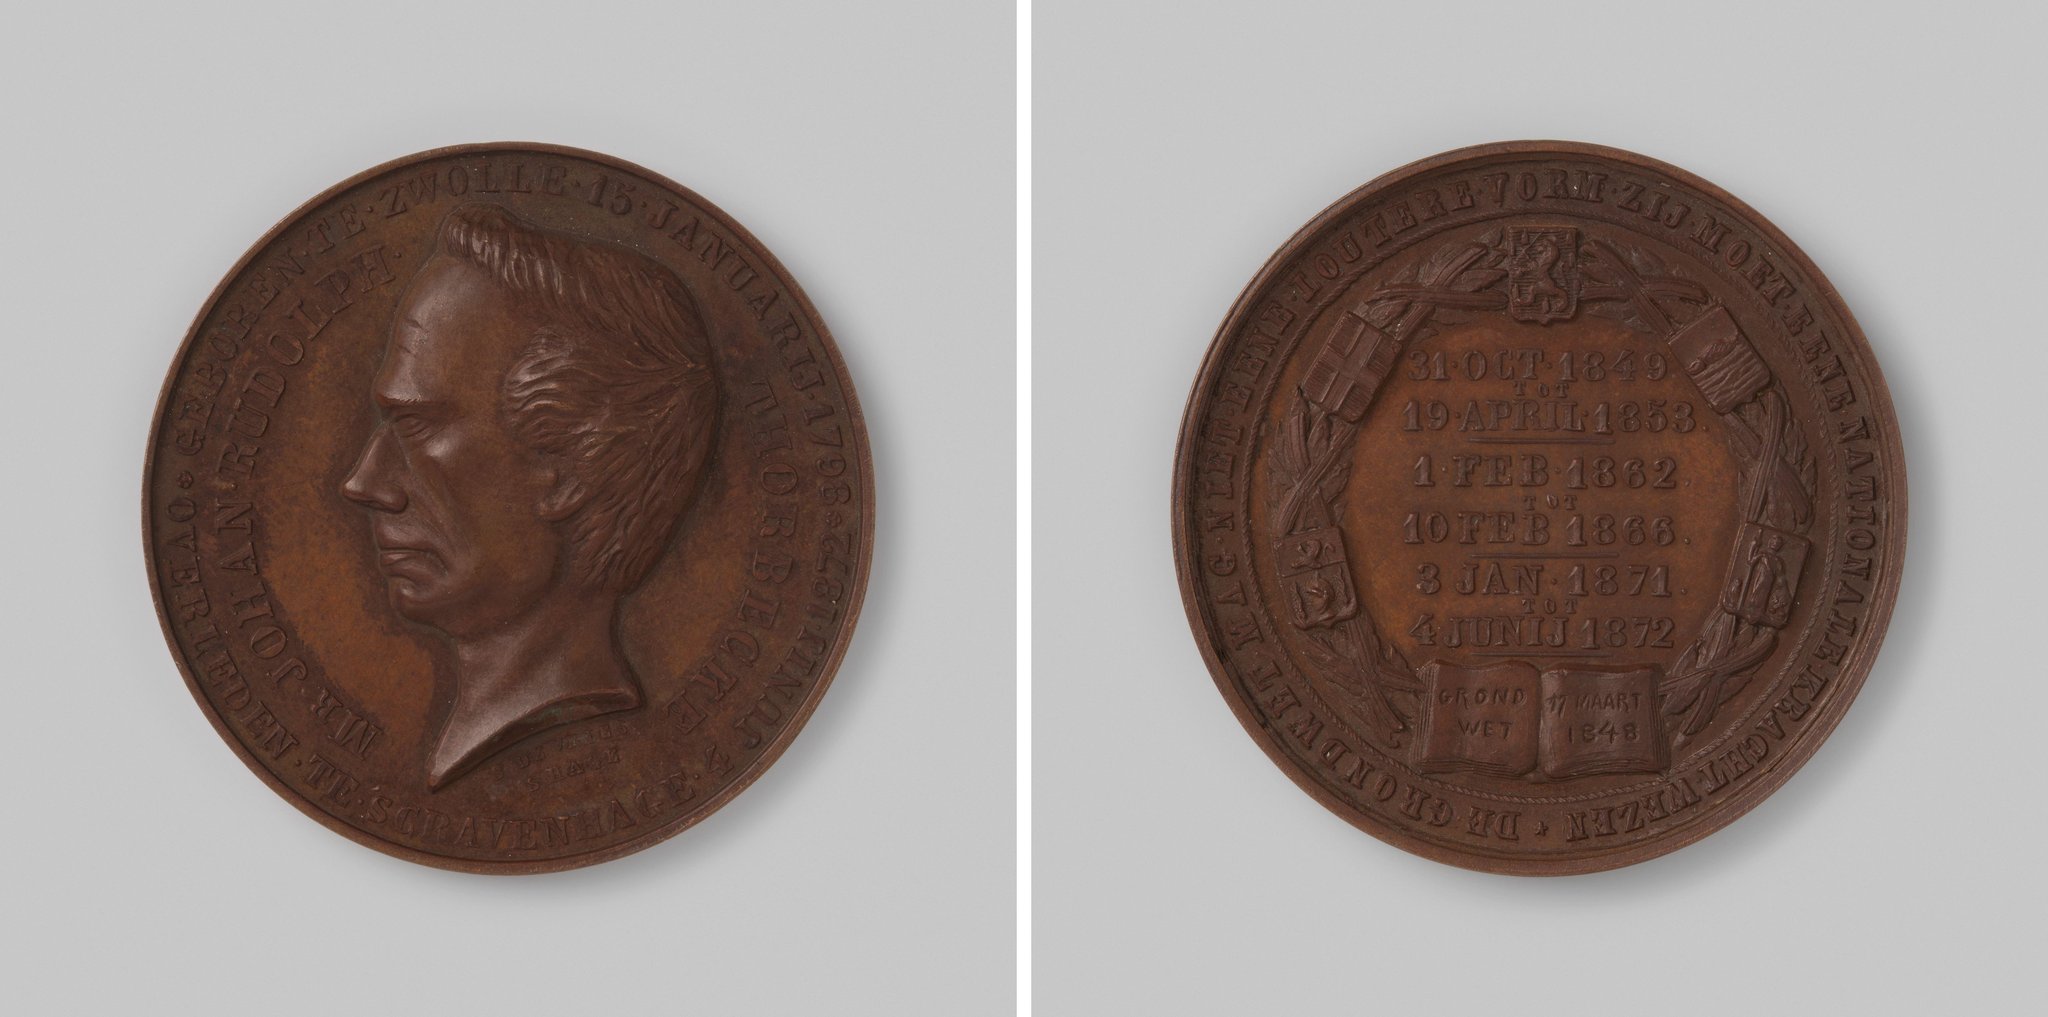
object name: medal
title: Overlijden van Johan Rudolph Thorbecke 1872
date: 1872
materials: bronze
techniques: striking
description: Bronzen penning, op de voorzijde het portret van Thorbecke naar links met dubbel omschrift, op de keerzijde negen regels tekst binnen een lauwerkrans waarop vijf wapenschilden en een opengeslagen boek, met omschrift.